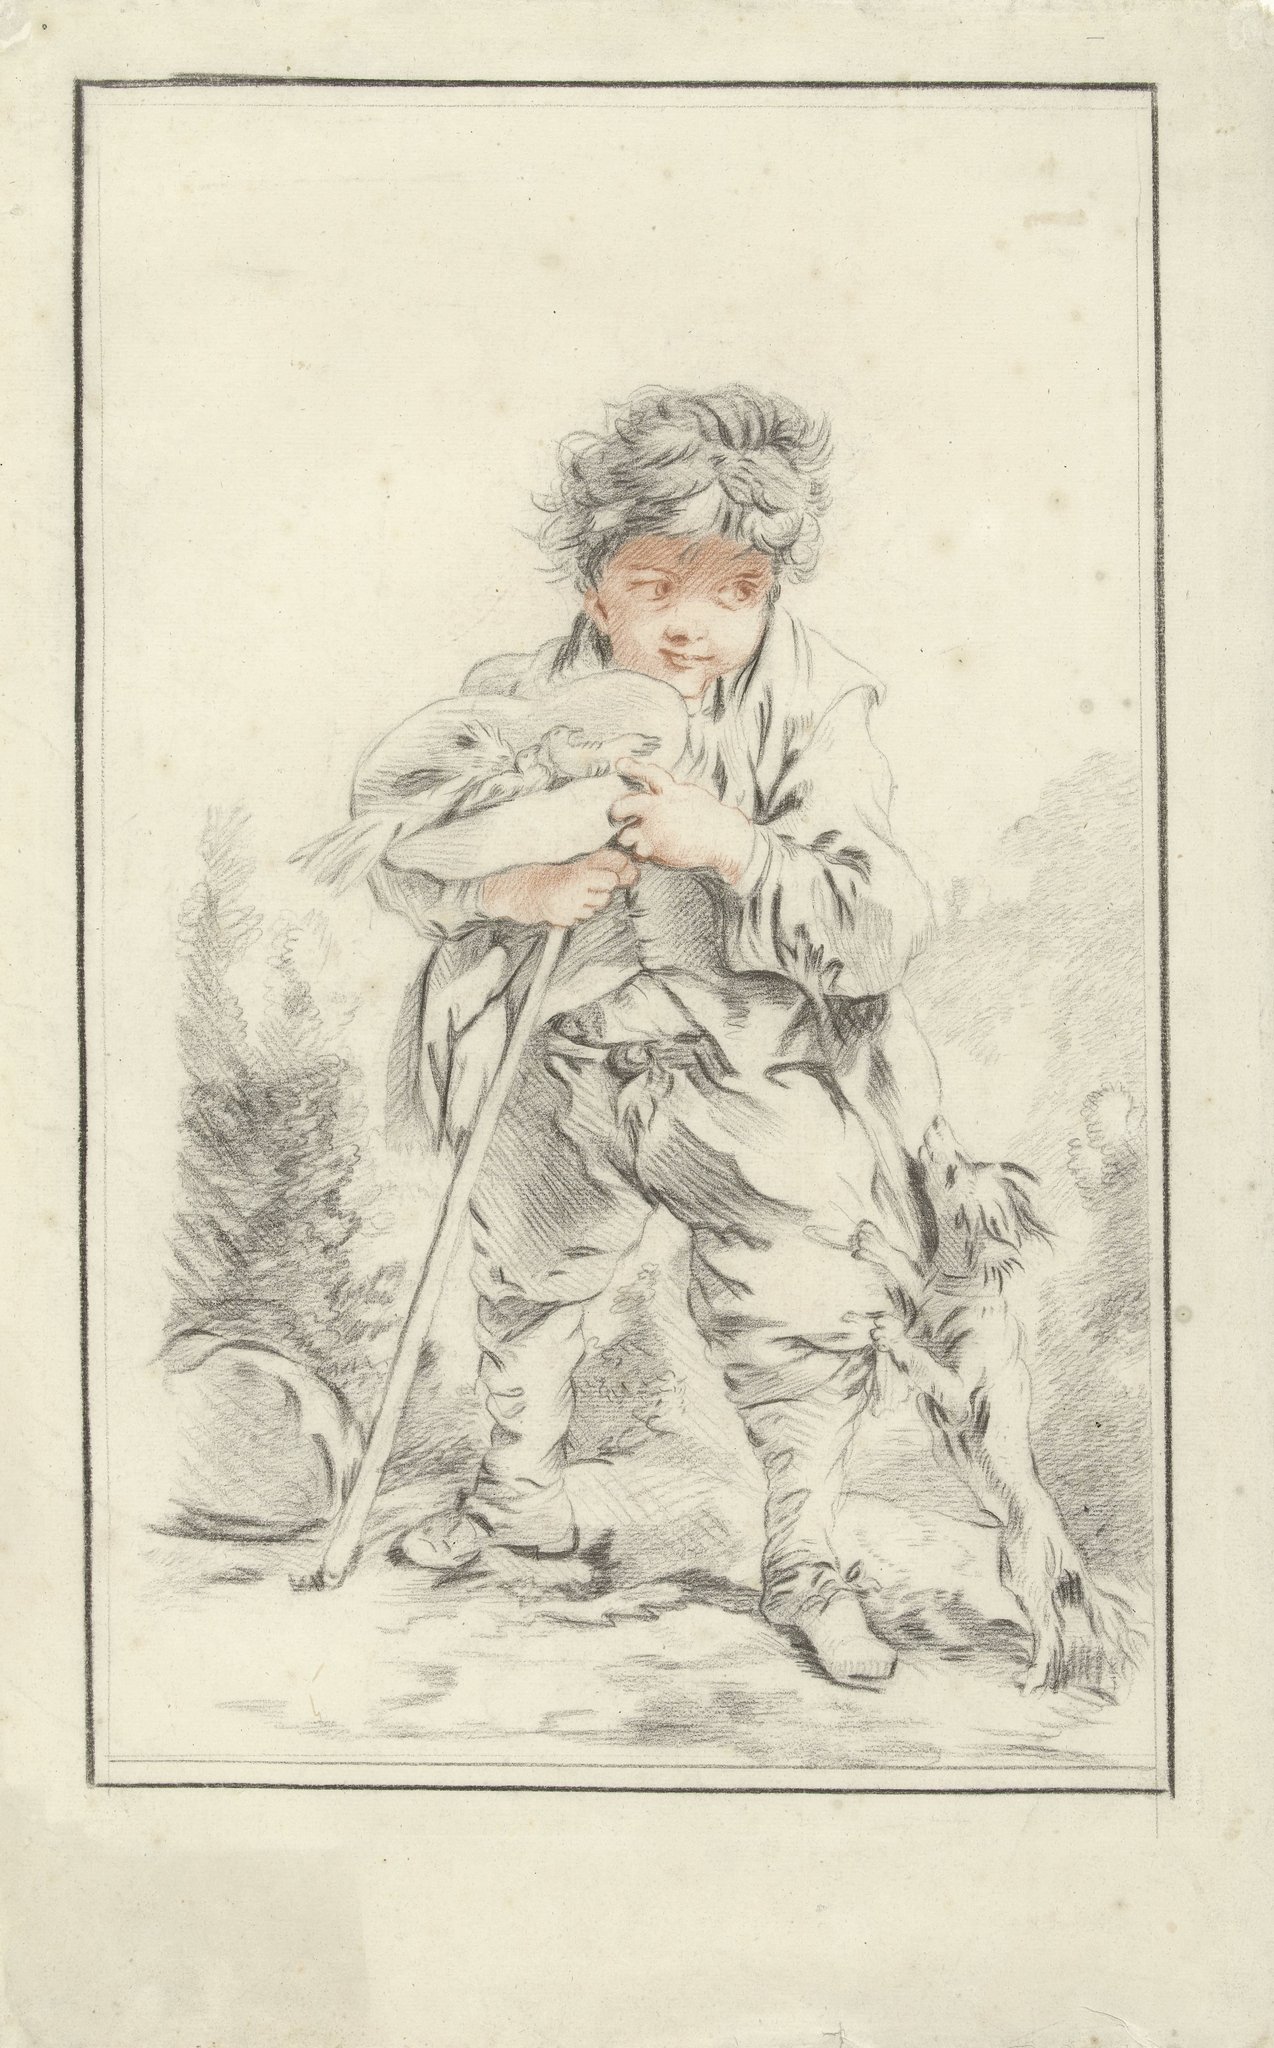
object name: drawing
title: Jongen met in zijn hoed twee vogels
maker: Anonymous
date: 1732-1800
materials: chalk, paper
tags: birds, boy (child between toddler and youth), dog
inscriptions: collector's mark, verso, lower right: Lugt 2228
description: Jongen draagt in zijn hoed twee vogels, rechts springt een hond blaffend tegen hem op.